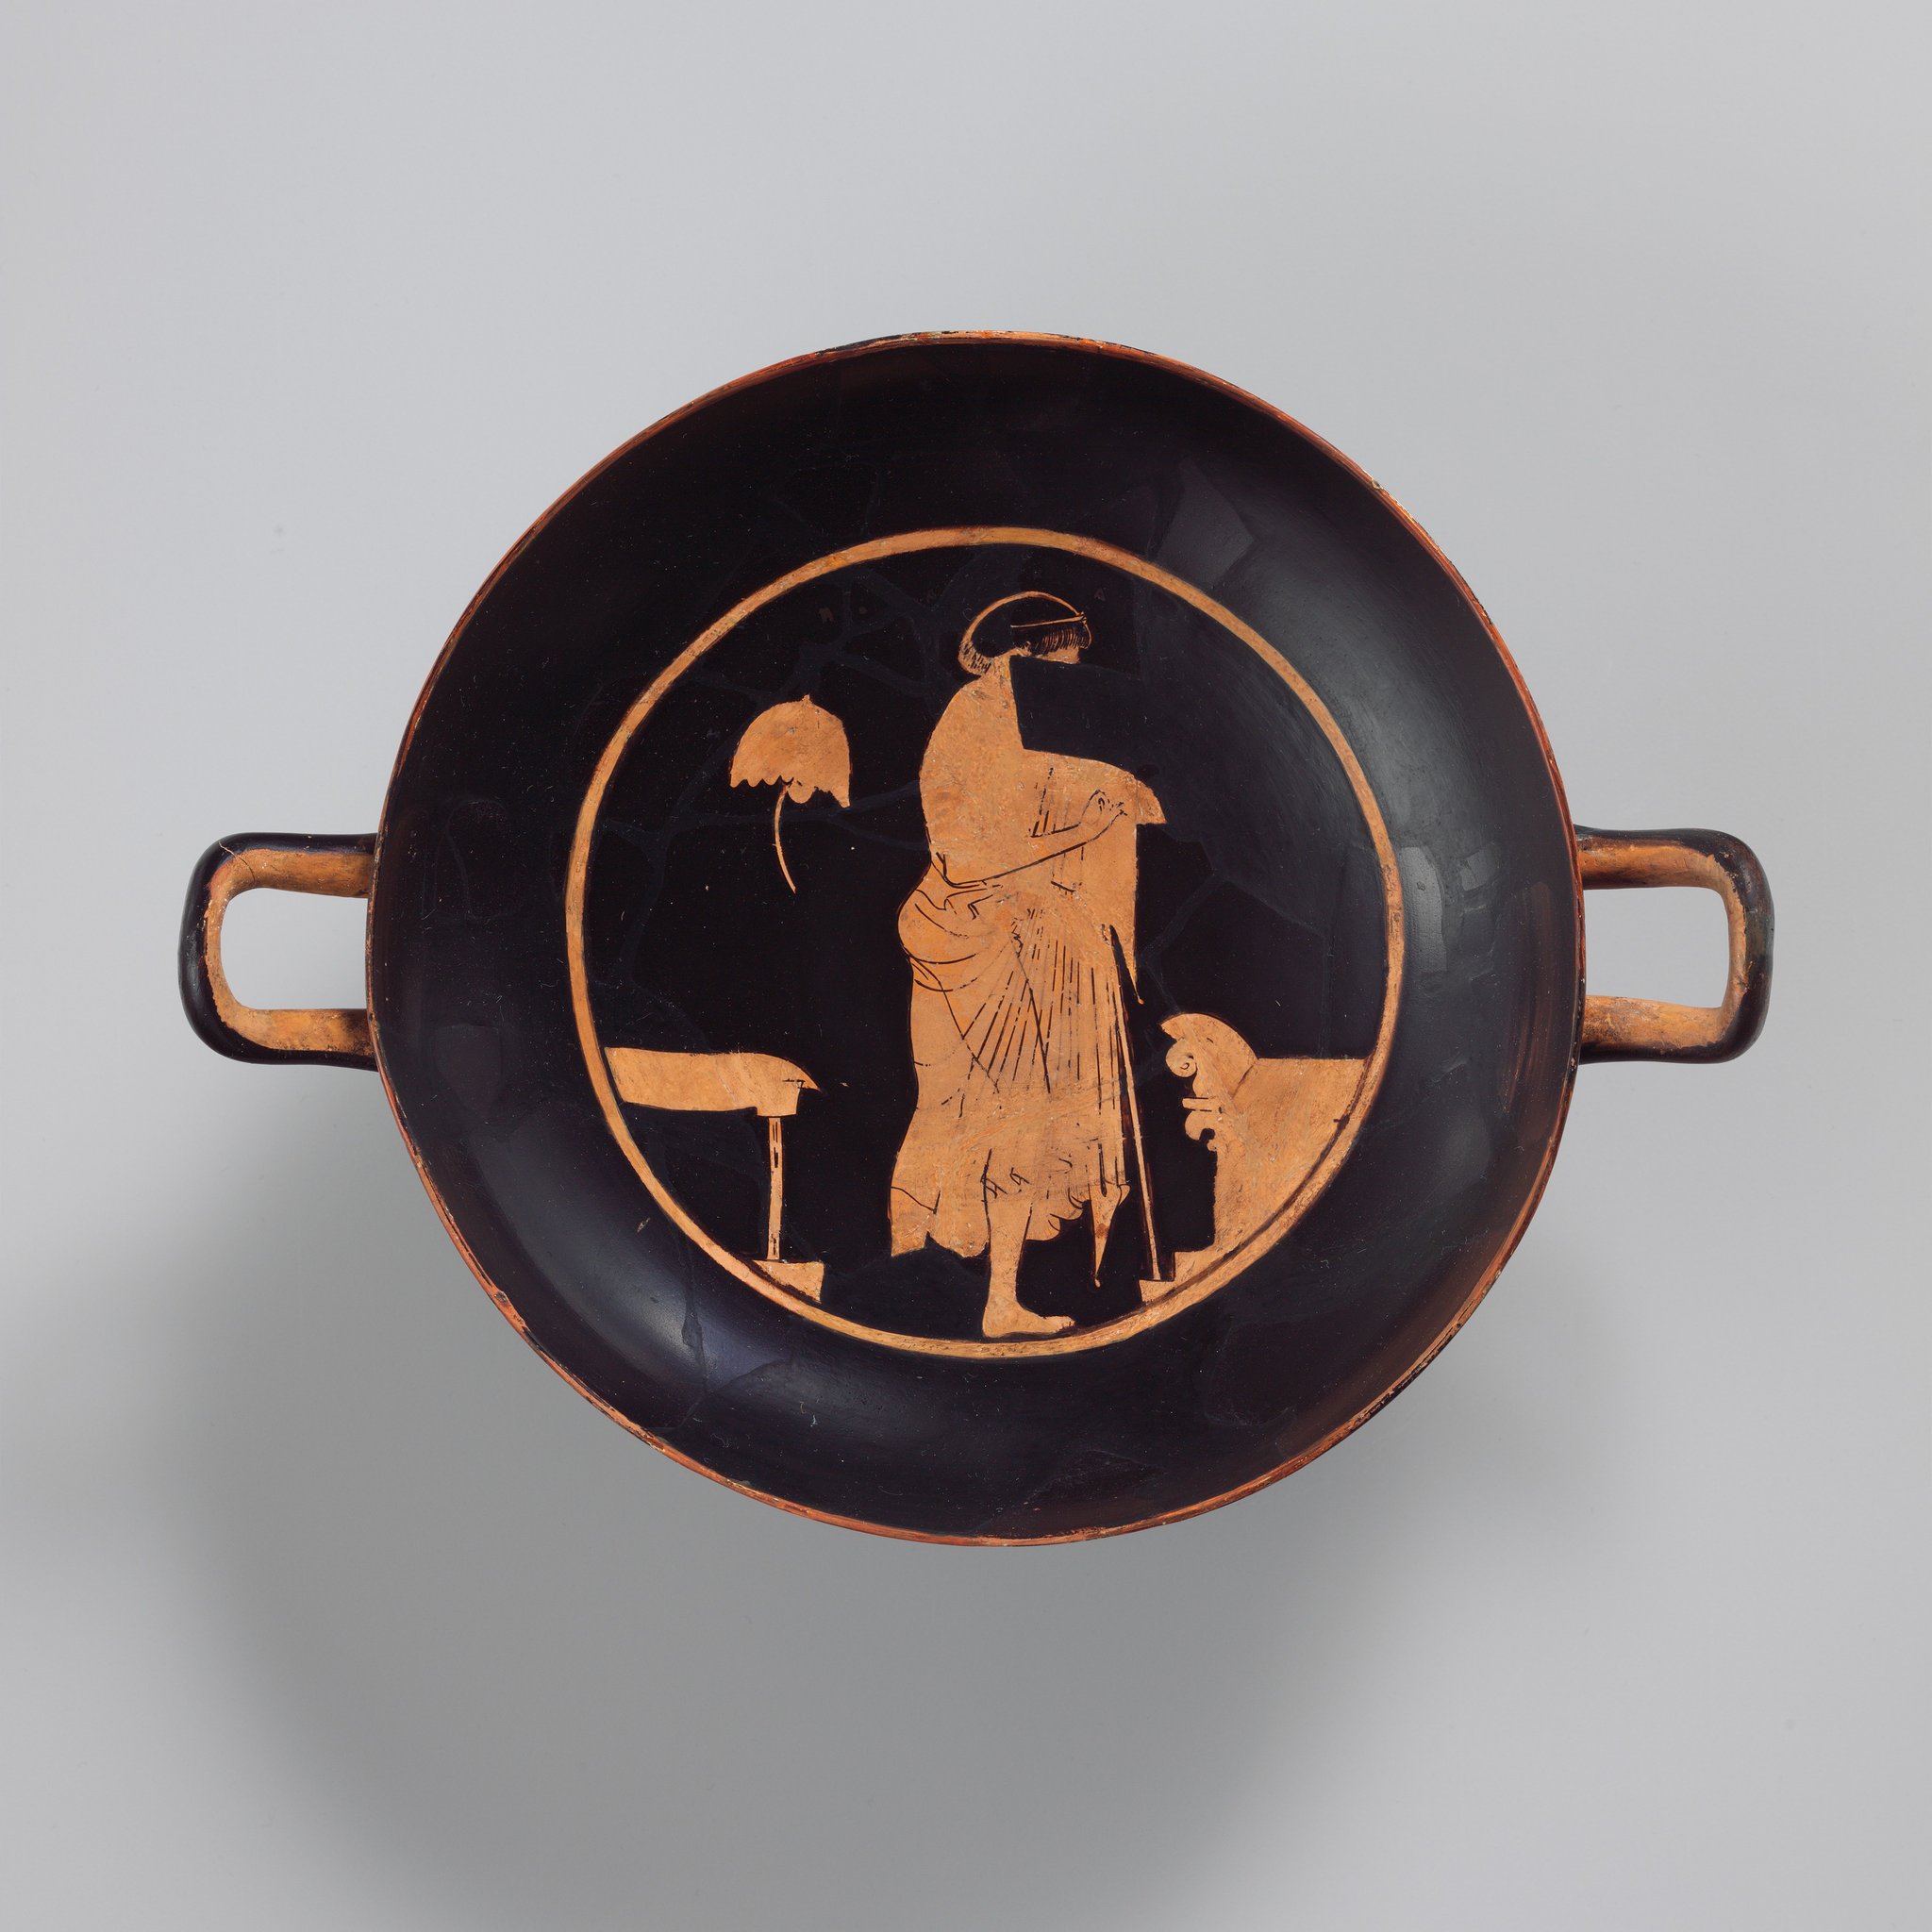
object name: kylix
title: Terracotta kylix (drinking cup)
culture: greek, attic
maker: apollodoros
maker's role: artist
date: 500-490 BCE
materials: terracotta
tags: human figures